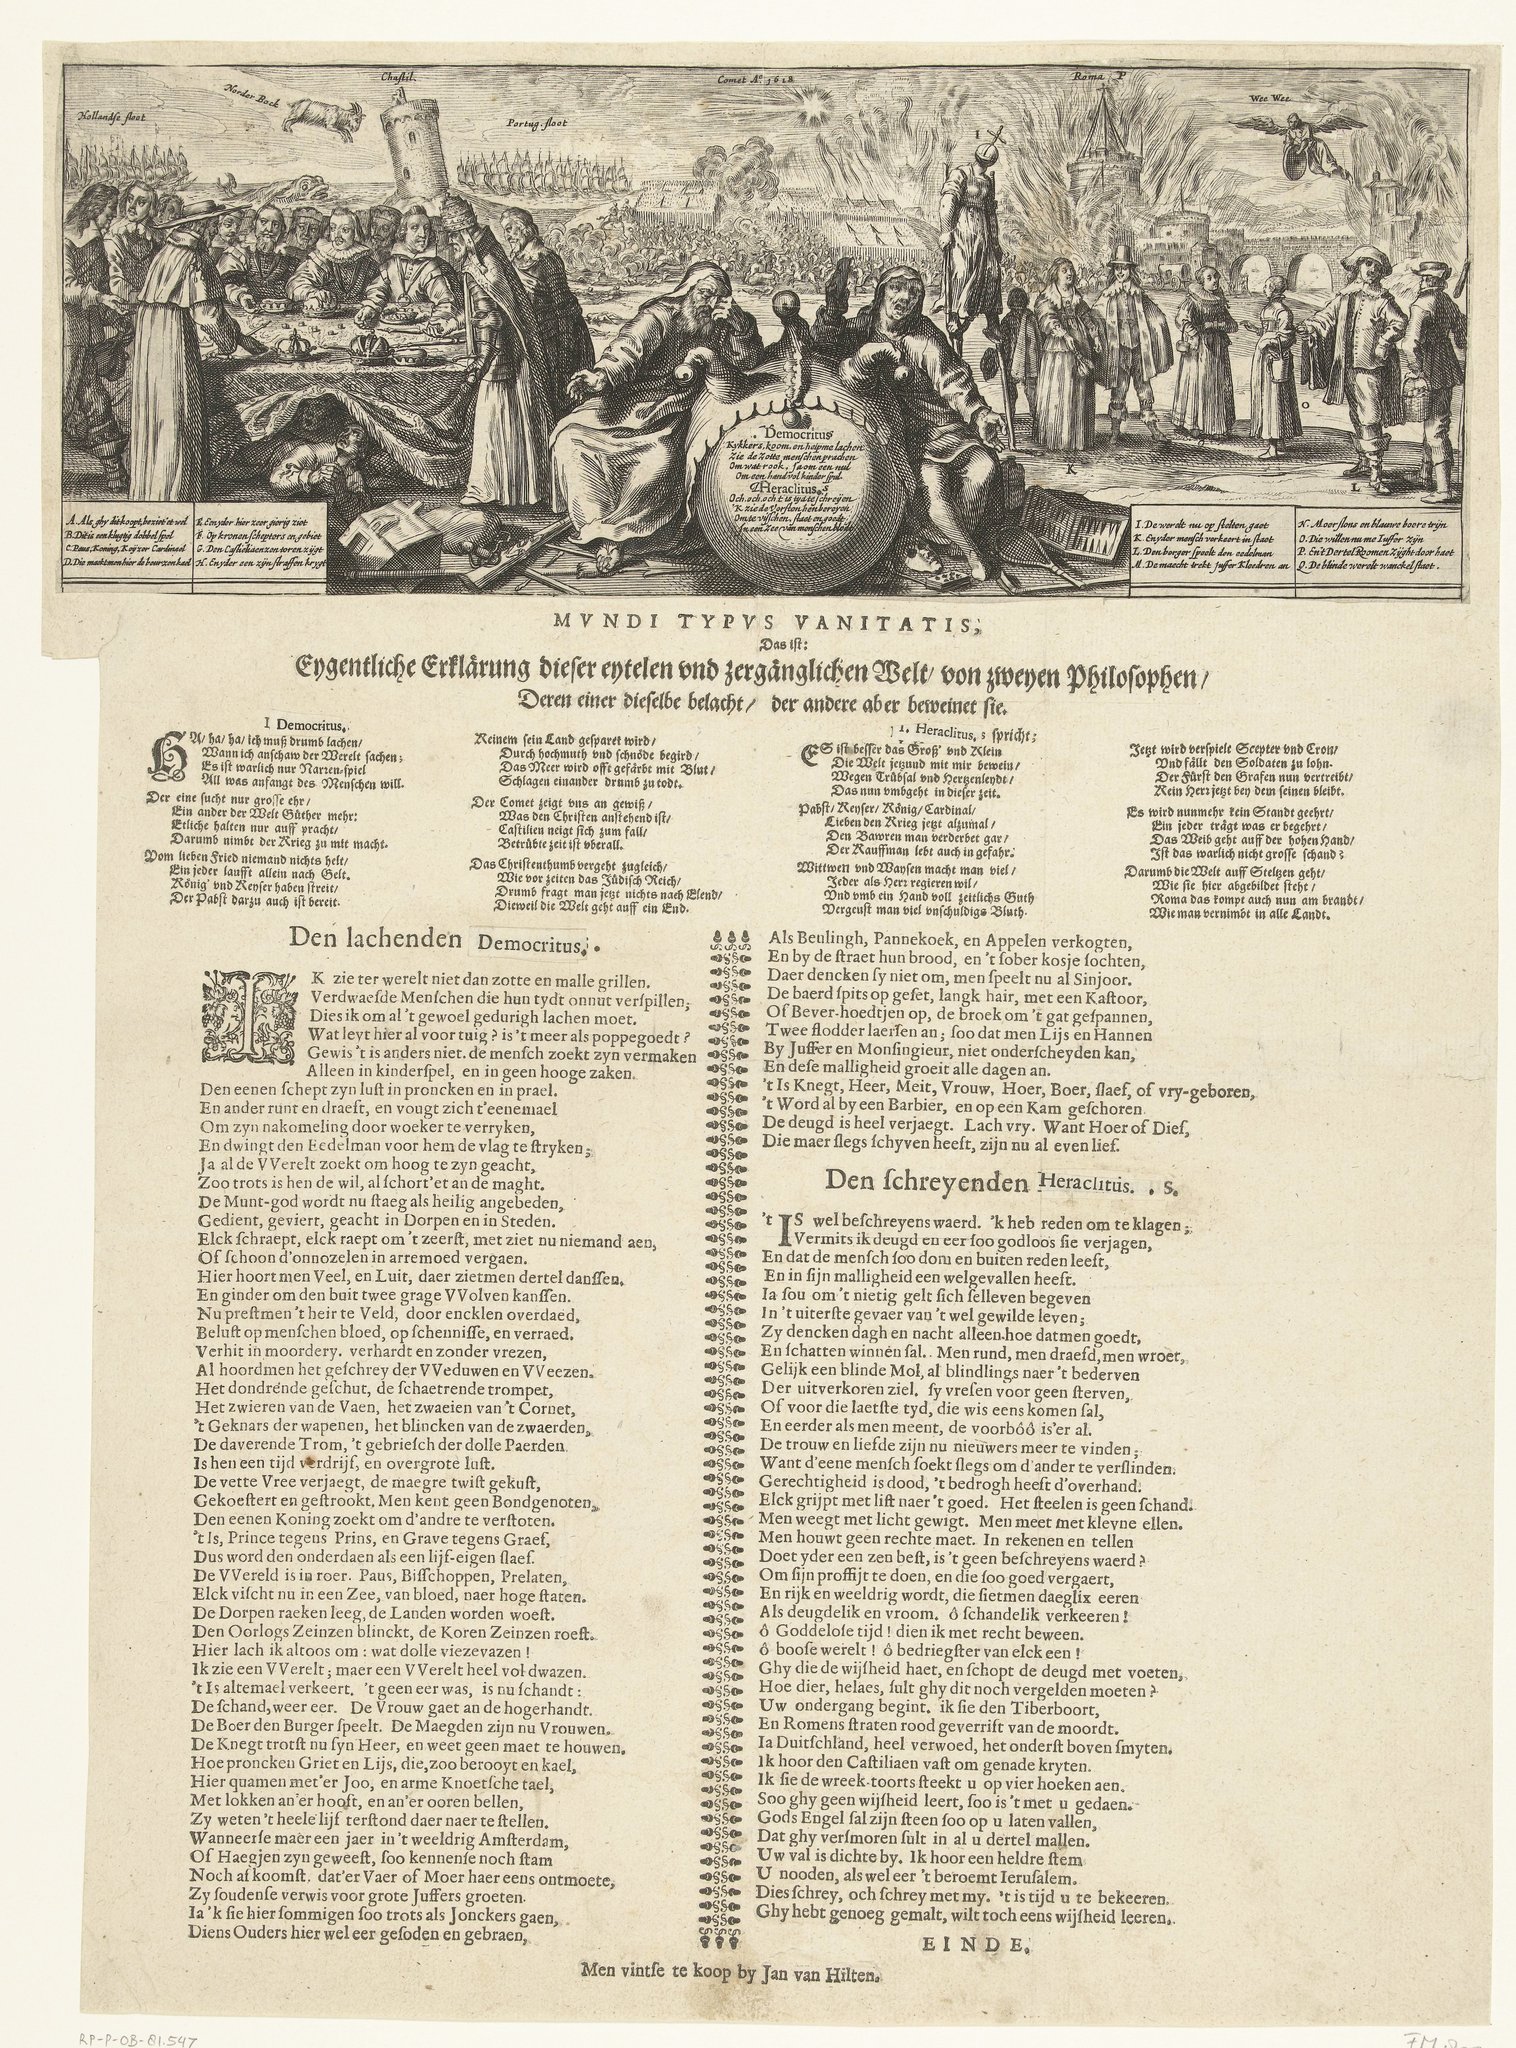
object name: print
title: Allegorie op de toestand in de wereld, ca. 1645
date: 1644-1645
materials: paper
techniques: engraving, etching, letterpress printing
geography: northern netherlands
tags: comet, dice, heraclitus, the weeping philosopher, and democritus, the laughing philosopher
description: Blad met bovenaan uitgeknipt en opgeplakt een allegorische voorstelling over de toestand van de wereld, ca. 1645. Links dobbelen de wereldlijke en geestelijke vorsten over het lot van de burger en boer. Rechts het burgerlijk leven en de wereld op stelten. Op de achtergrond oorlogen ter land en ter zee, in de hemel de ruiters van de Apocalypse en de komeet van 1628. Centraal de filosofen Democritus en Heraclites bij een wereldbol onder een narrenkap in gesprek. Dit gesprek is onderaan in 12 Duitse versjes en in 2 kolommen in het Nederlands afgedrukt.